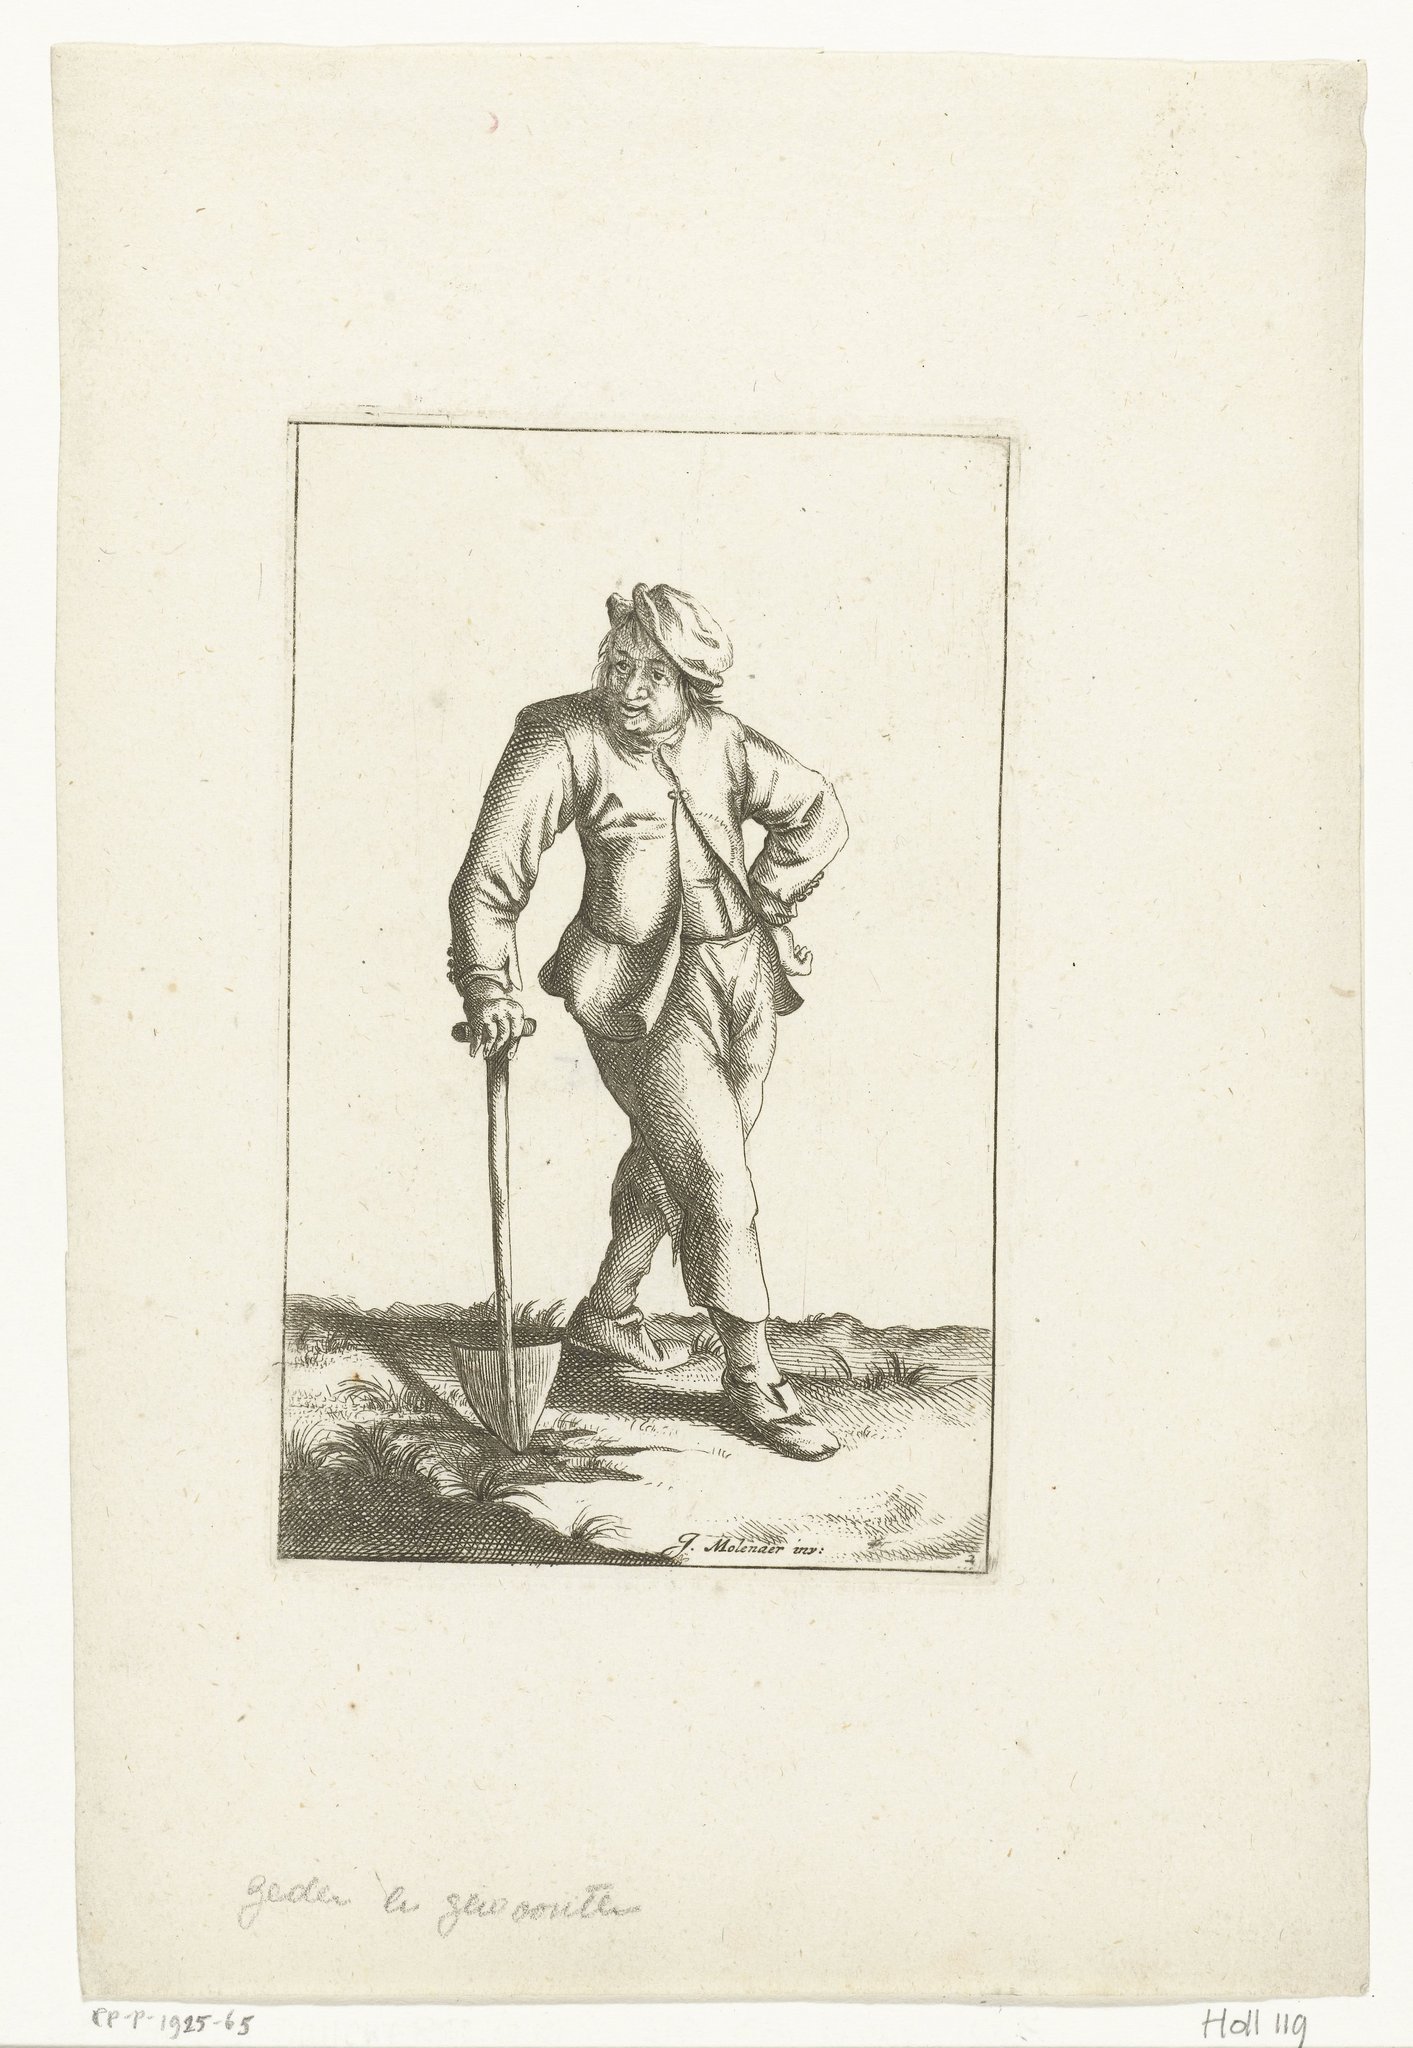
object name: print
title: Boer leunt op schop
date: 1613-1656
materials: paper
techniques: etching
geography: netherlands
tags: farmers, agricultural implements: spade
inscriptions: collector's mark: Lugt 2228, collector's mark: Lugt 2233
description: Prent uit serie van zes prenten met boeren naar verschillende kunstenaars: Jan Miense Molenaer, Pieter Quast, Hendrik Potuyl en Adriaen van Ostade